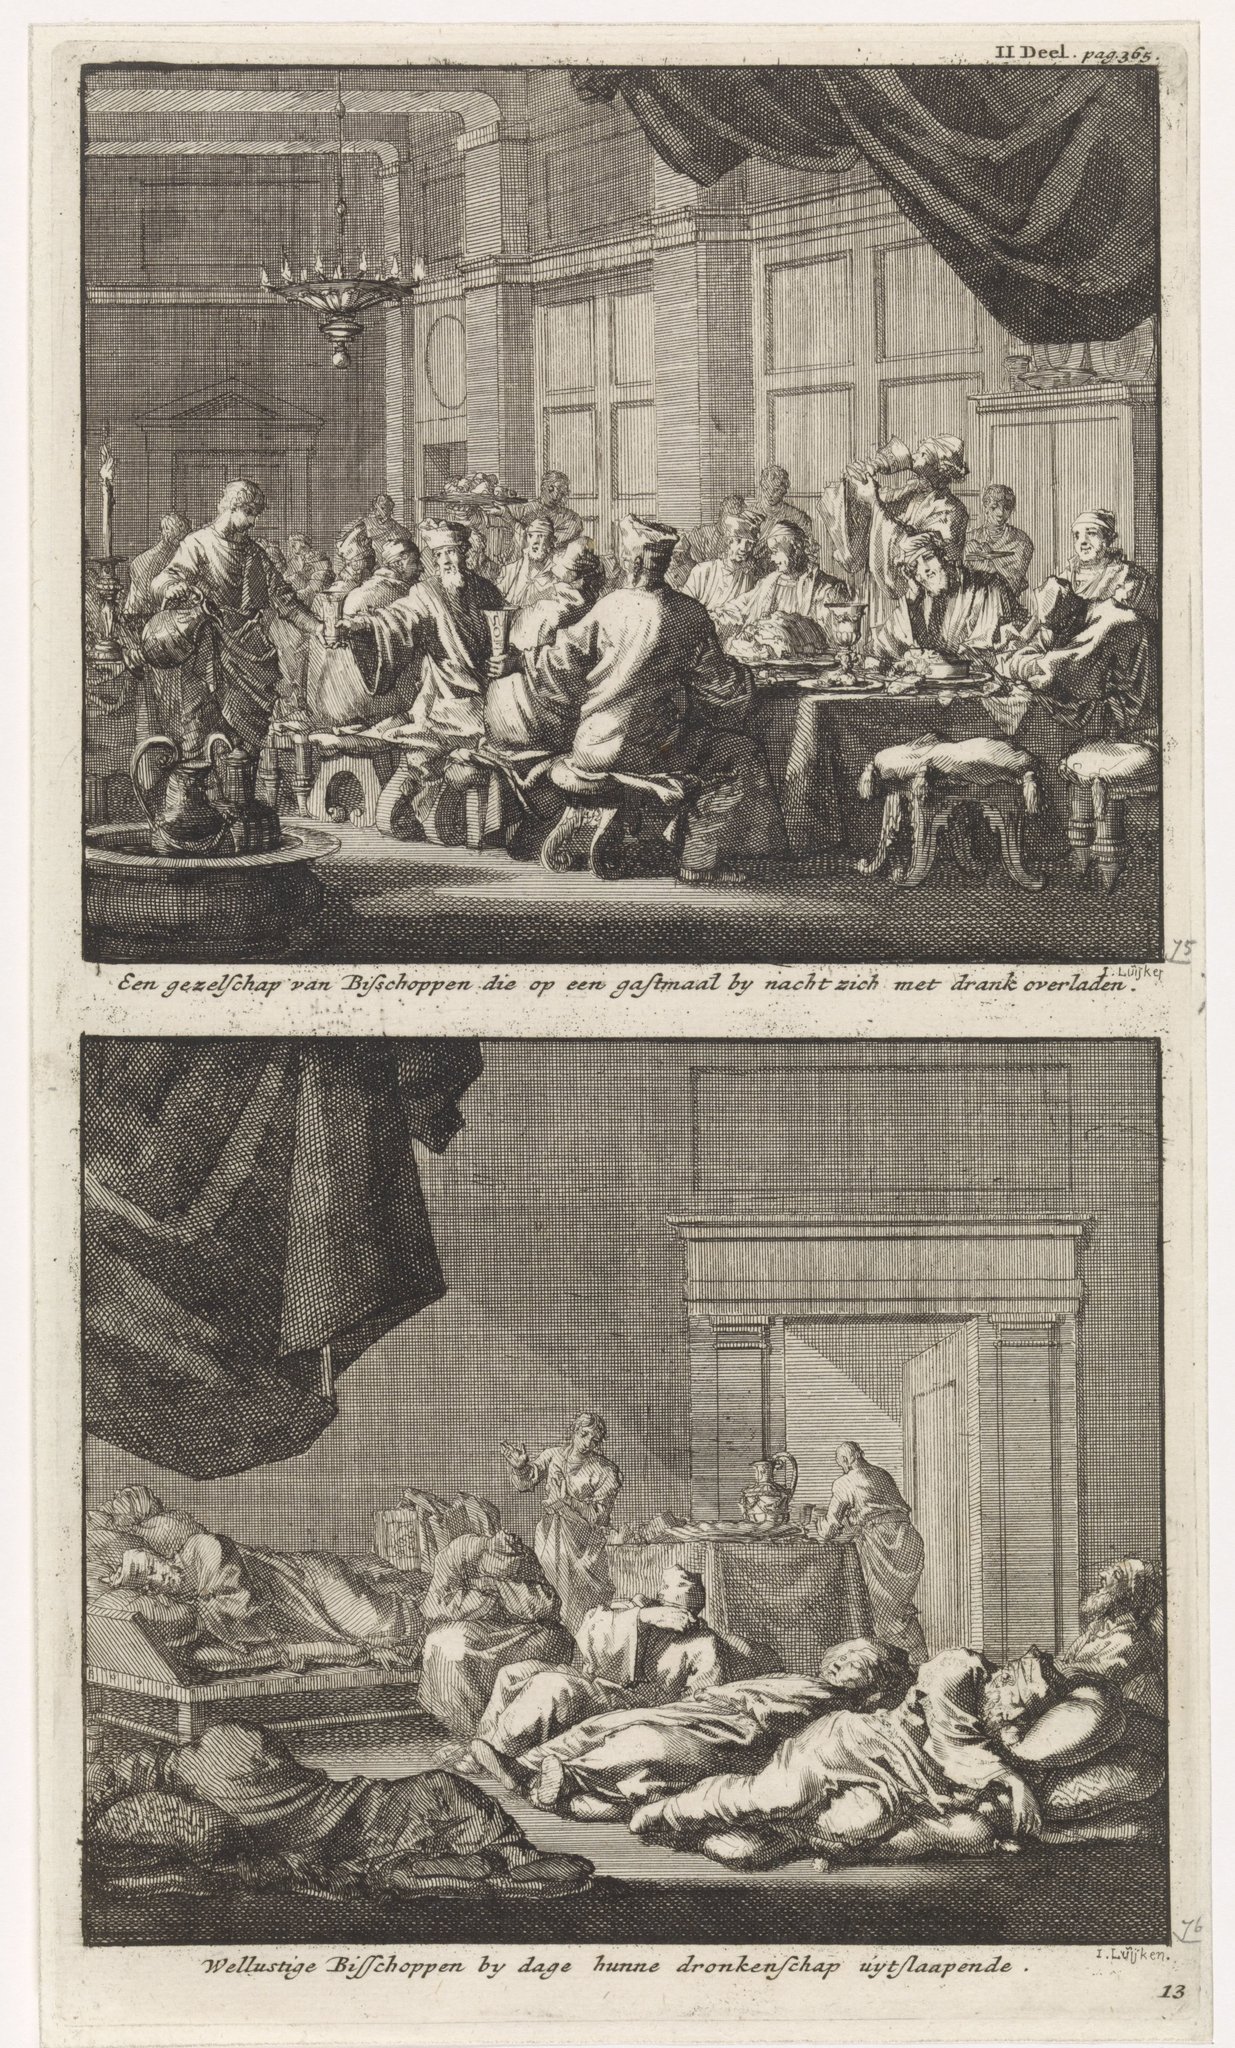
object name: print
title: Een gezelschap van Bisschoppen die op een gastmaal by nacht zich met drank overladen / Wellustige Bisschoppen by dage hunne dronkenschap uytslaapende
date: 1701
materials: paper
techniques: etching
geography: amsterdam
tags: the early christian churches, e.g. armenians, copts, syrians, day from sunrise to sunset, carousal, drinking-bout, orgy, archbishop, bishop, etc. (roman catholic), drunkenness, sleeping on the ground, night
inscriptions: collector's mark: Lugt 2228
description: Twee voorstellingen op een plaat. Boven: rondom een langwerpige tafel een groep vroegchristelijke bisschoppen. Ze doen zich te goed aan drank en eten. Onder: enkele dronken bisschoppen slapen hun roes uit in een slaapvertrek.